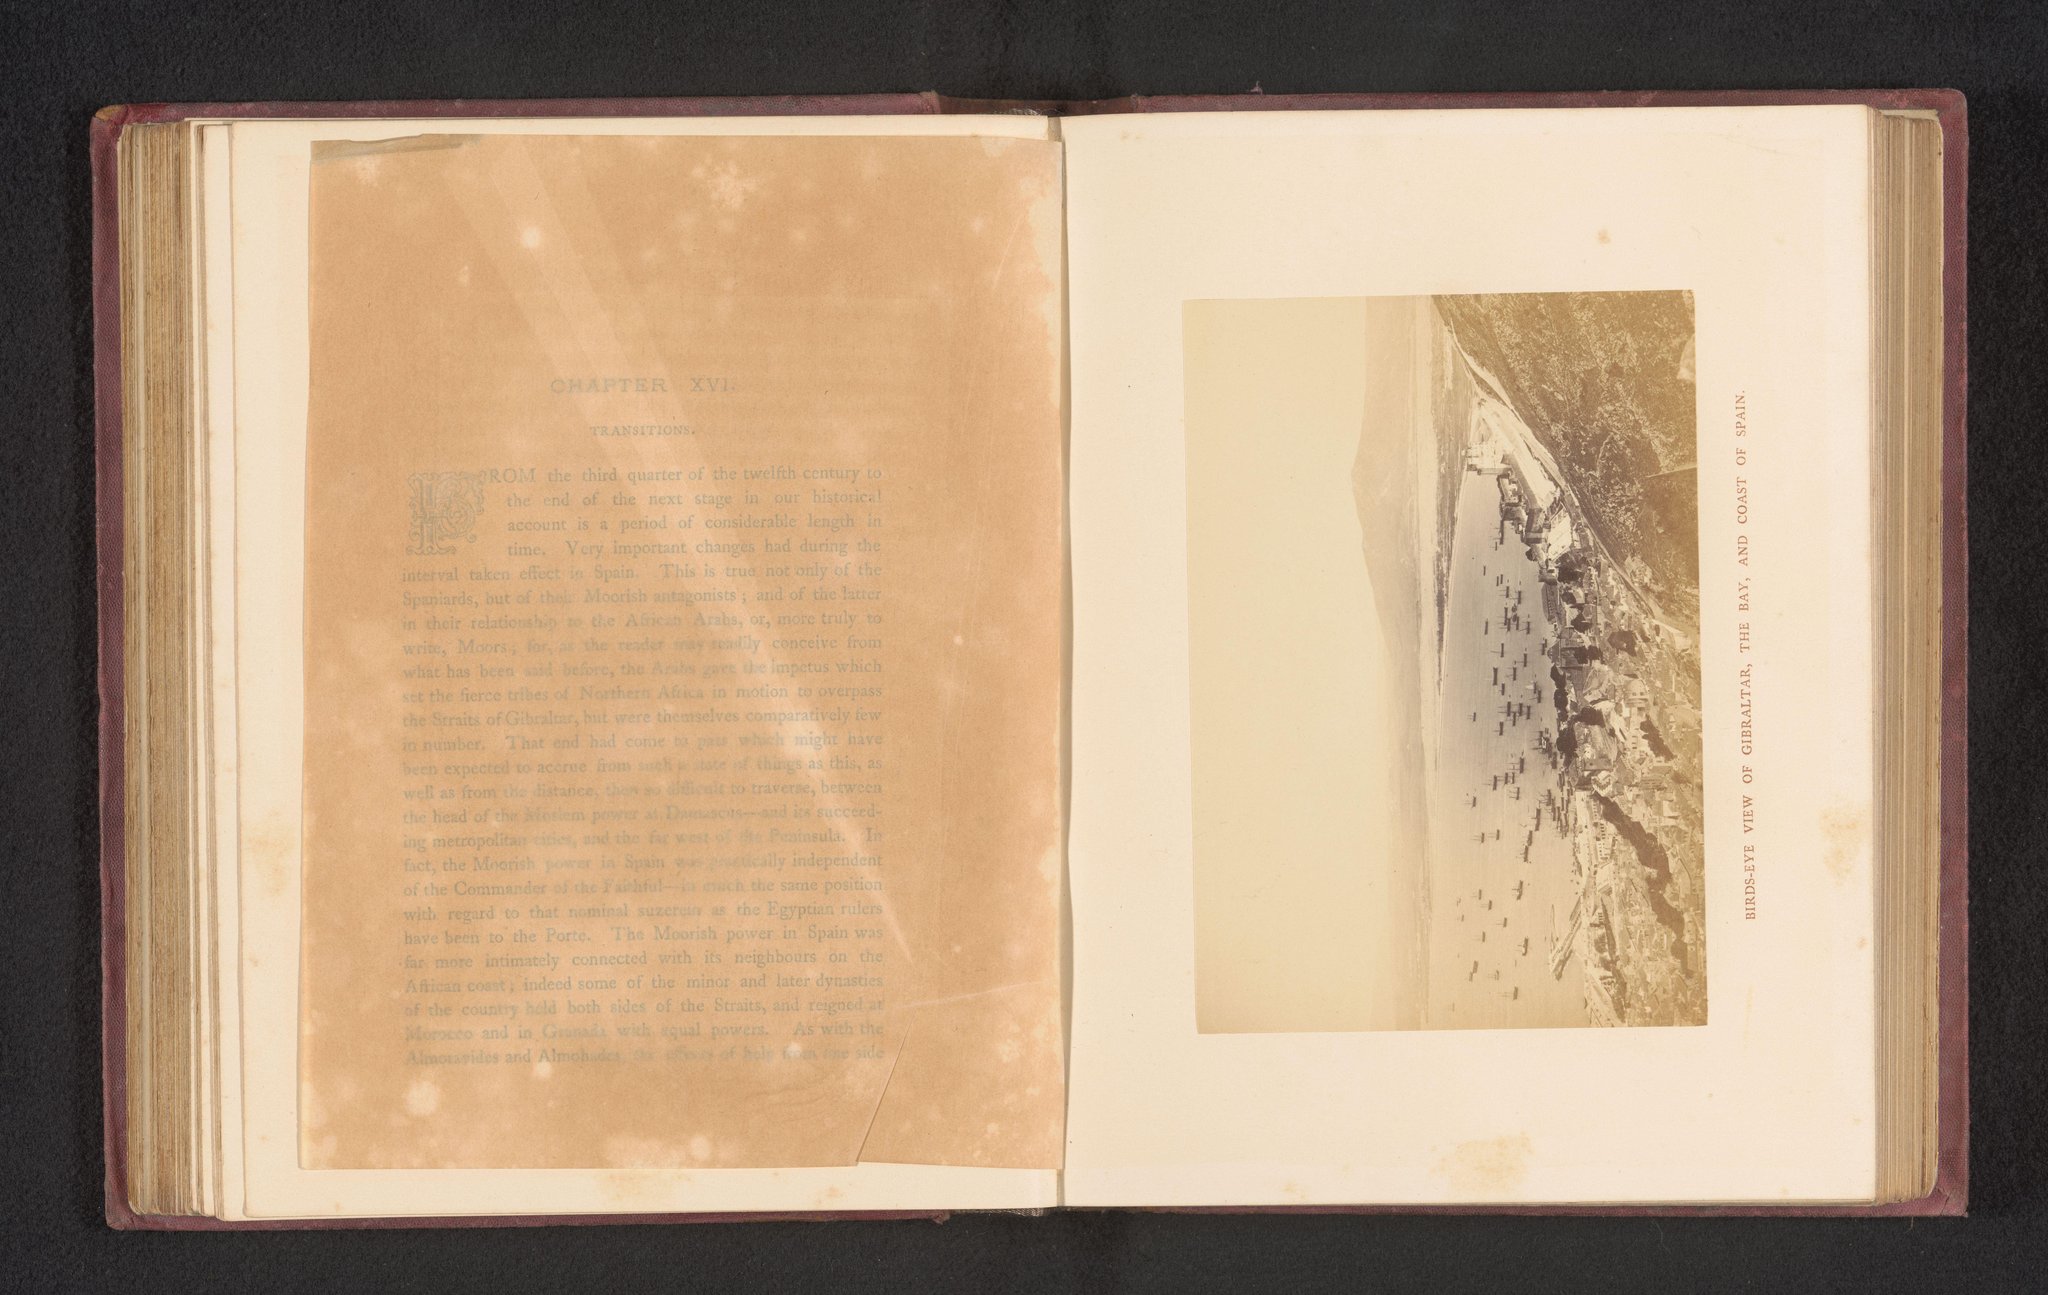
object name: photograph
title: Birds-eye view of Gibraltar, the bay, and coast of Spain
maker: j.h. mann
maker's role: fotograaf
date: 1860-1870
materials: photographic support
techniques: albumen print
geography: gibraltar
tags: gulf, bay, ships (in general)